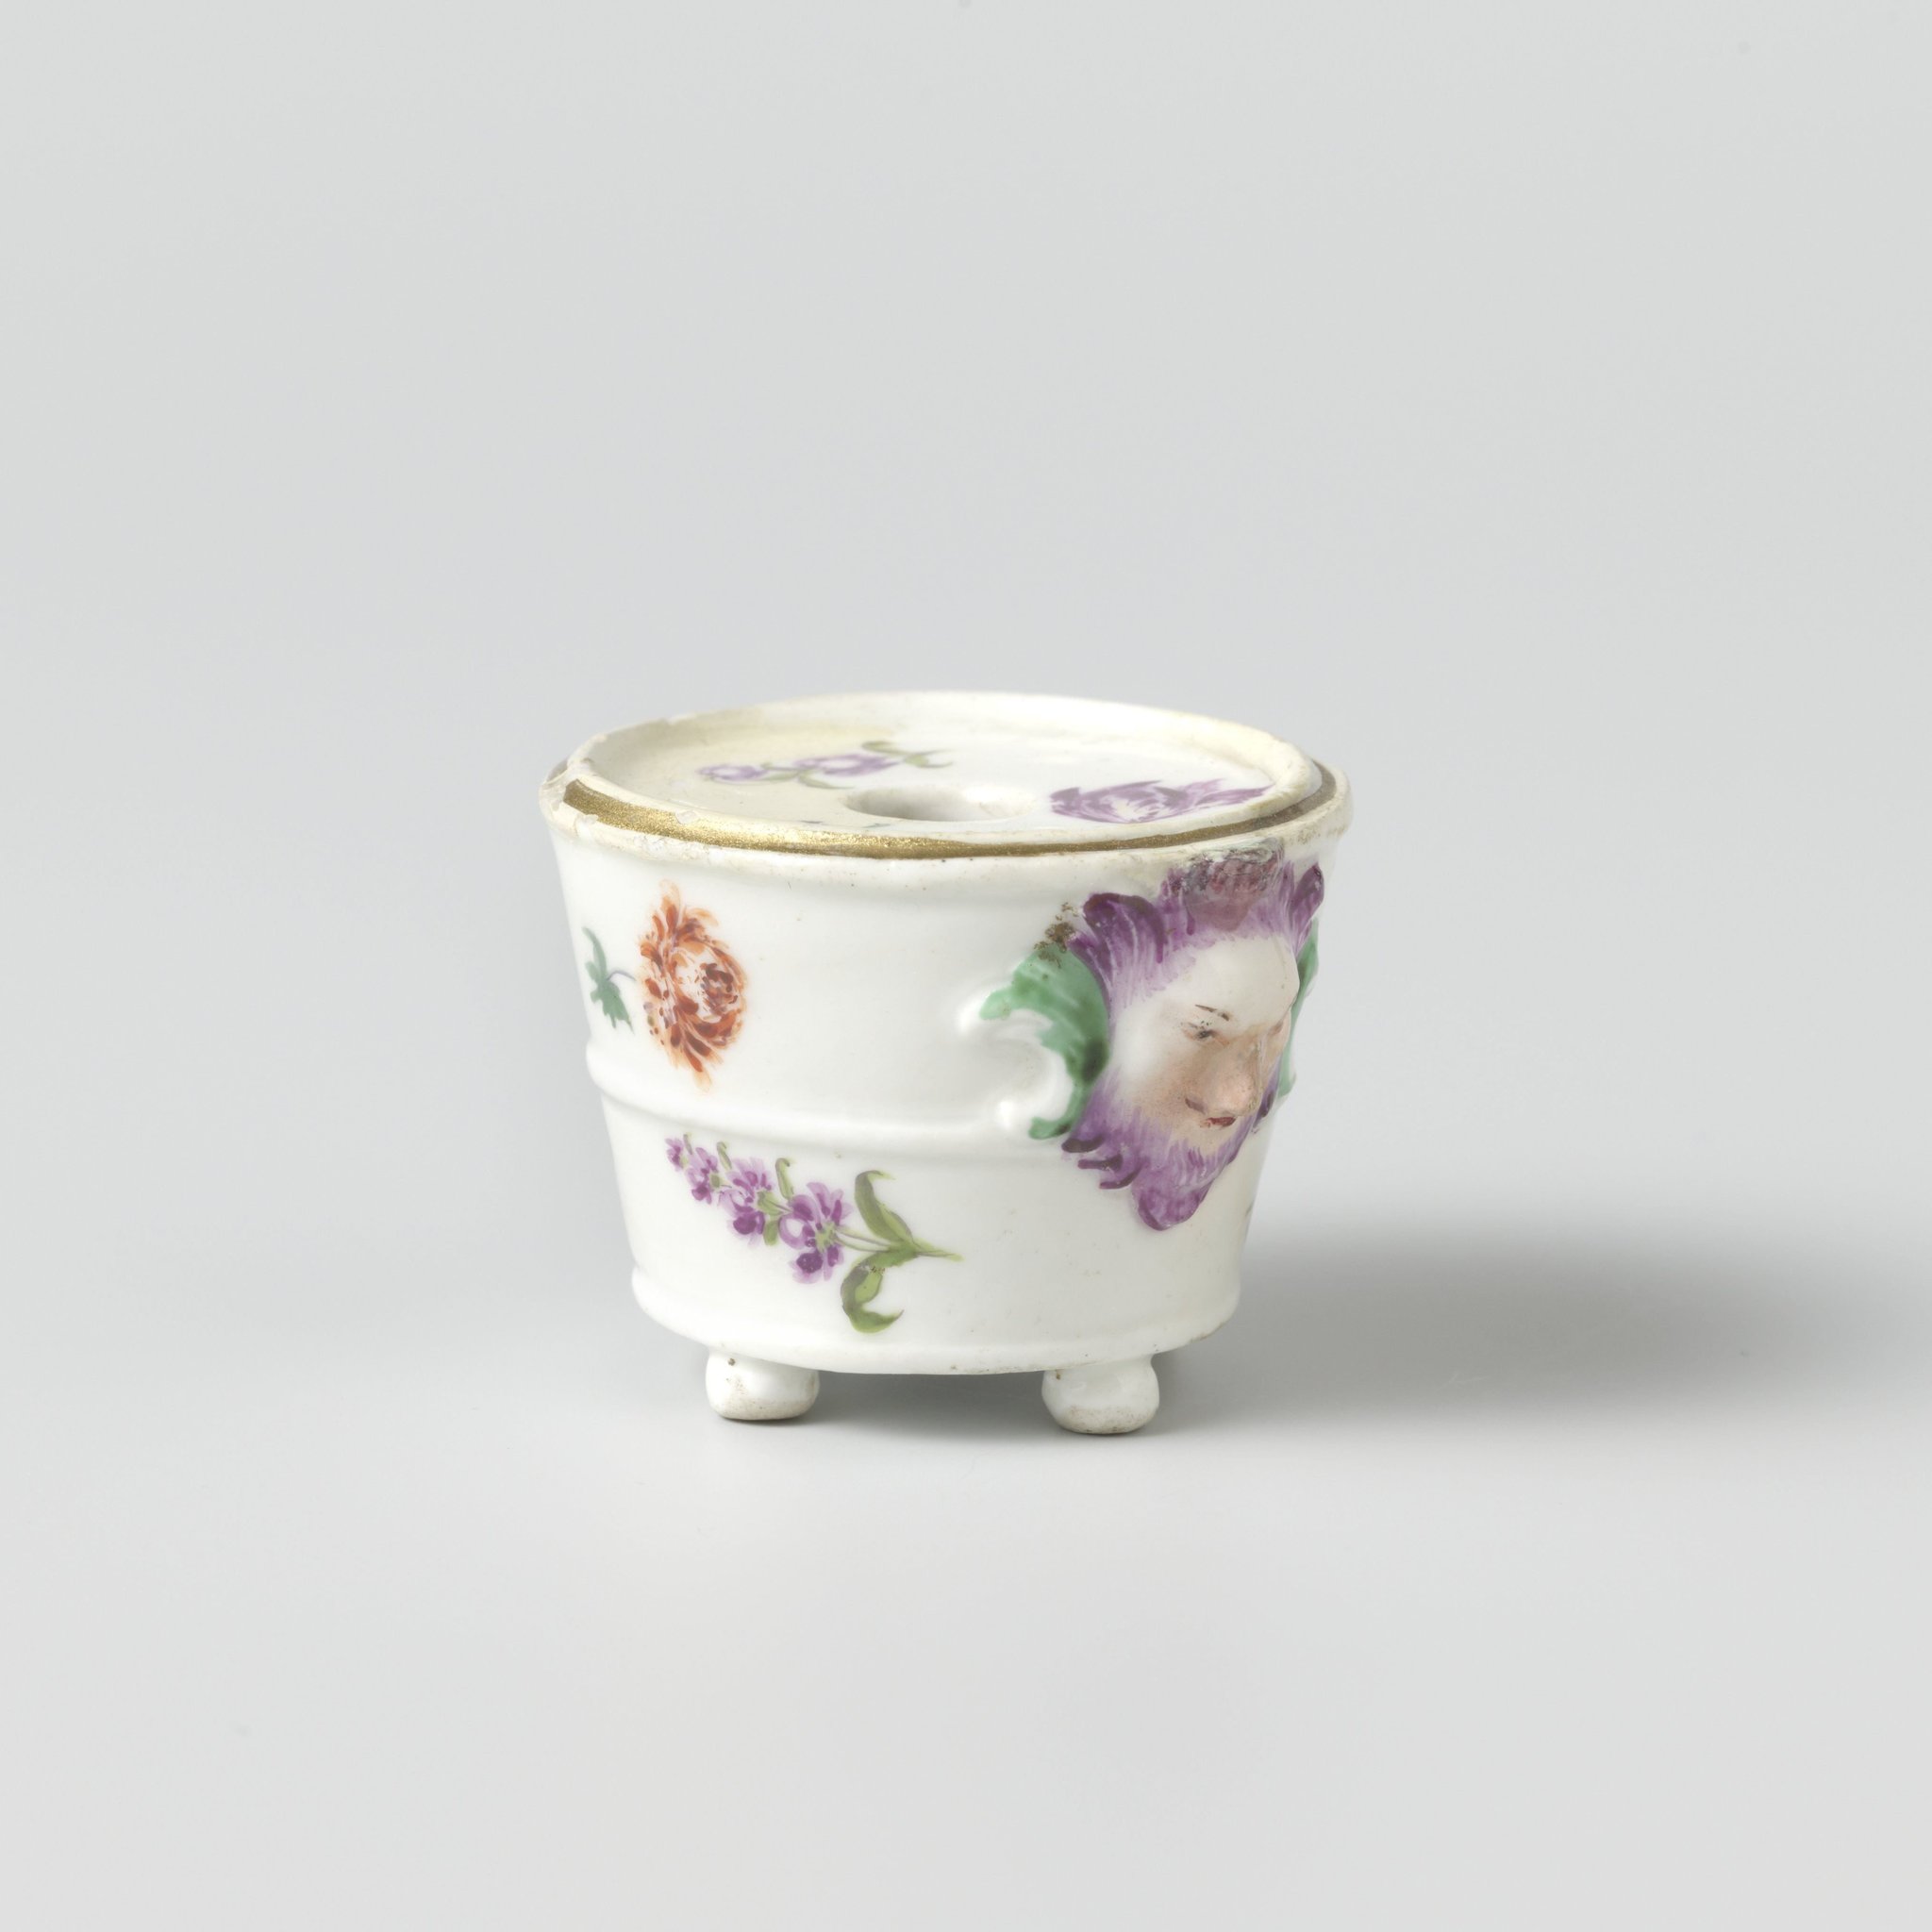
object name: miniature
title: Bloempot, veelkleurig beschilderd met bloemen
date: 1750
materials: porcelain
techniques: painted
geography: meissen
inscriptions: factory mark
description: Bloempot van beschilderd porselein. De pot is bekervormig en staat op vier bolvormige poten. De pot is versierd met twee maskers in reliëf en is beschilderd met veelkleurige bloemen. De bloempot is gemerkt.